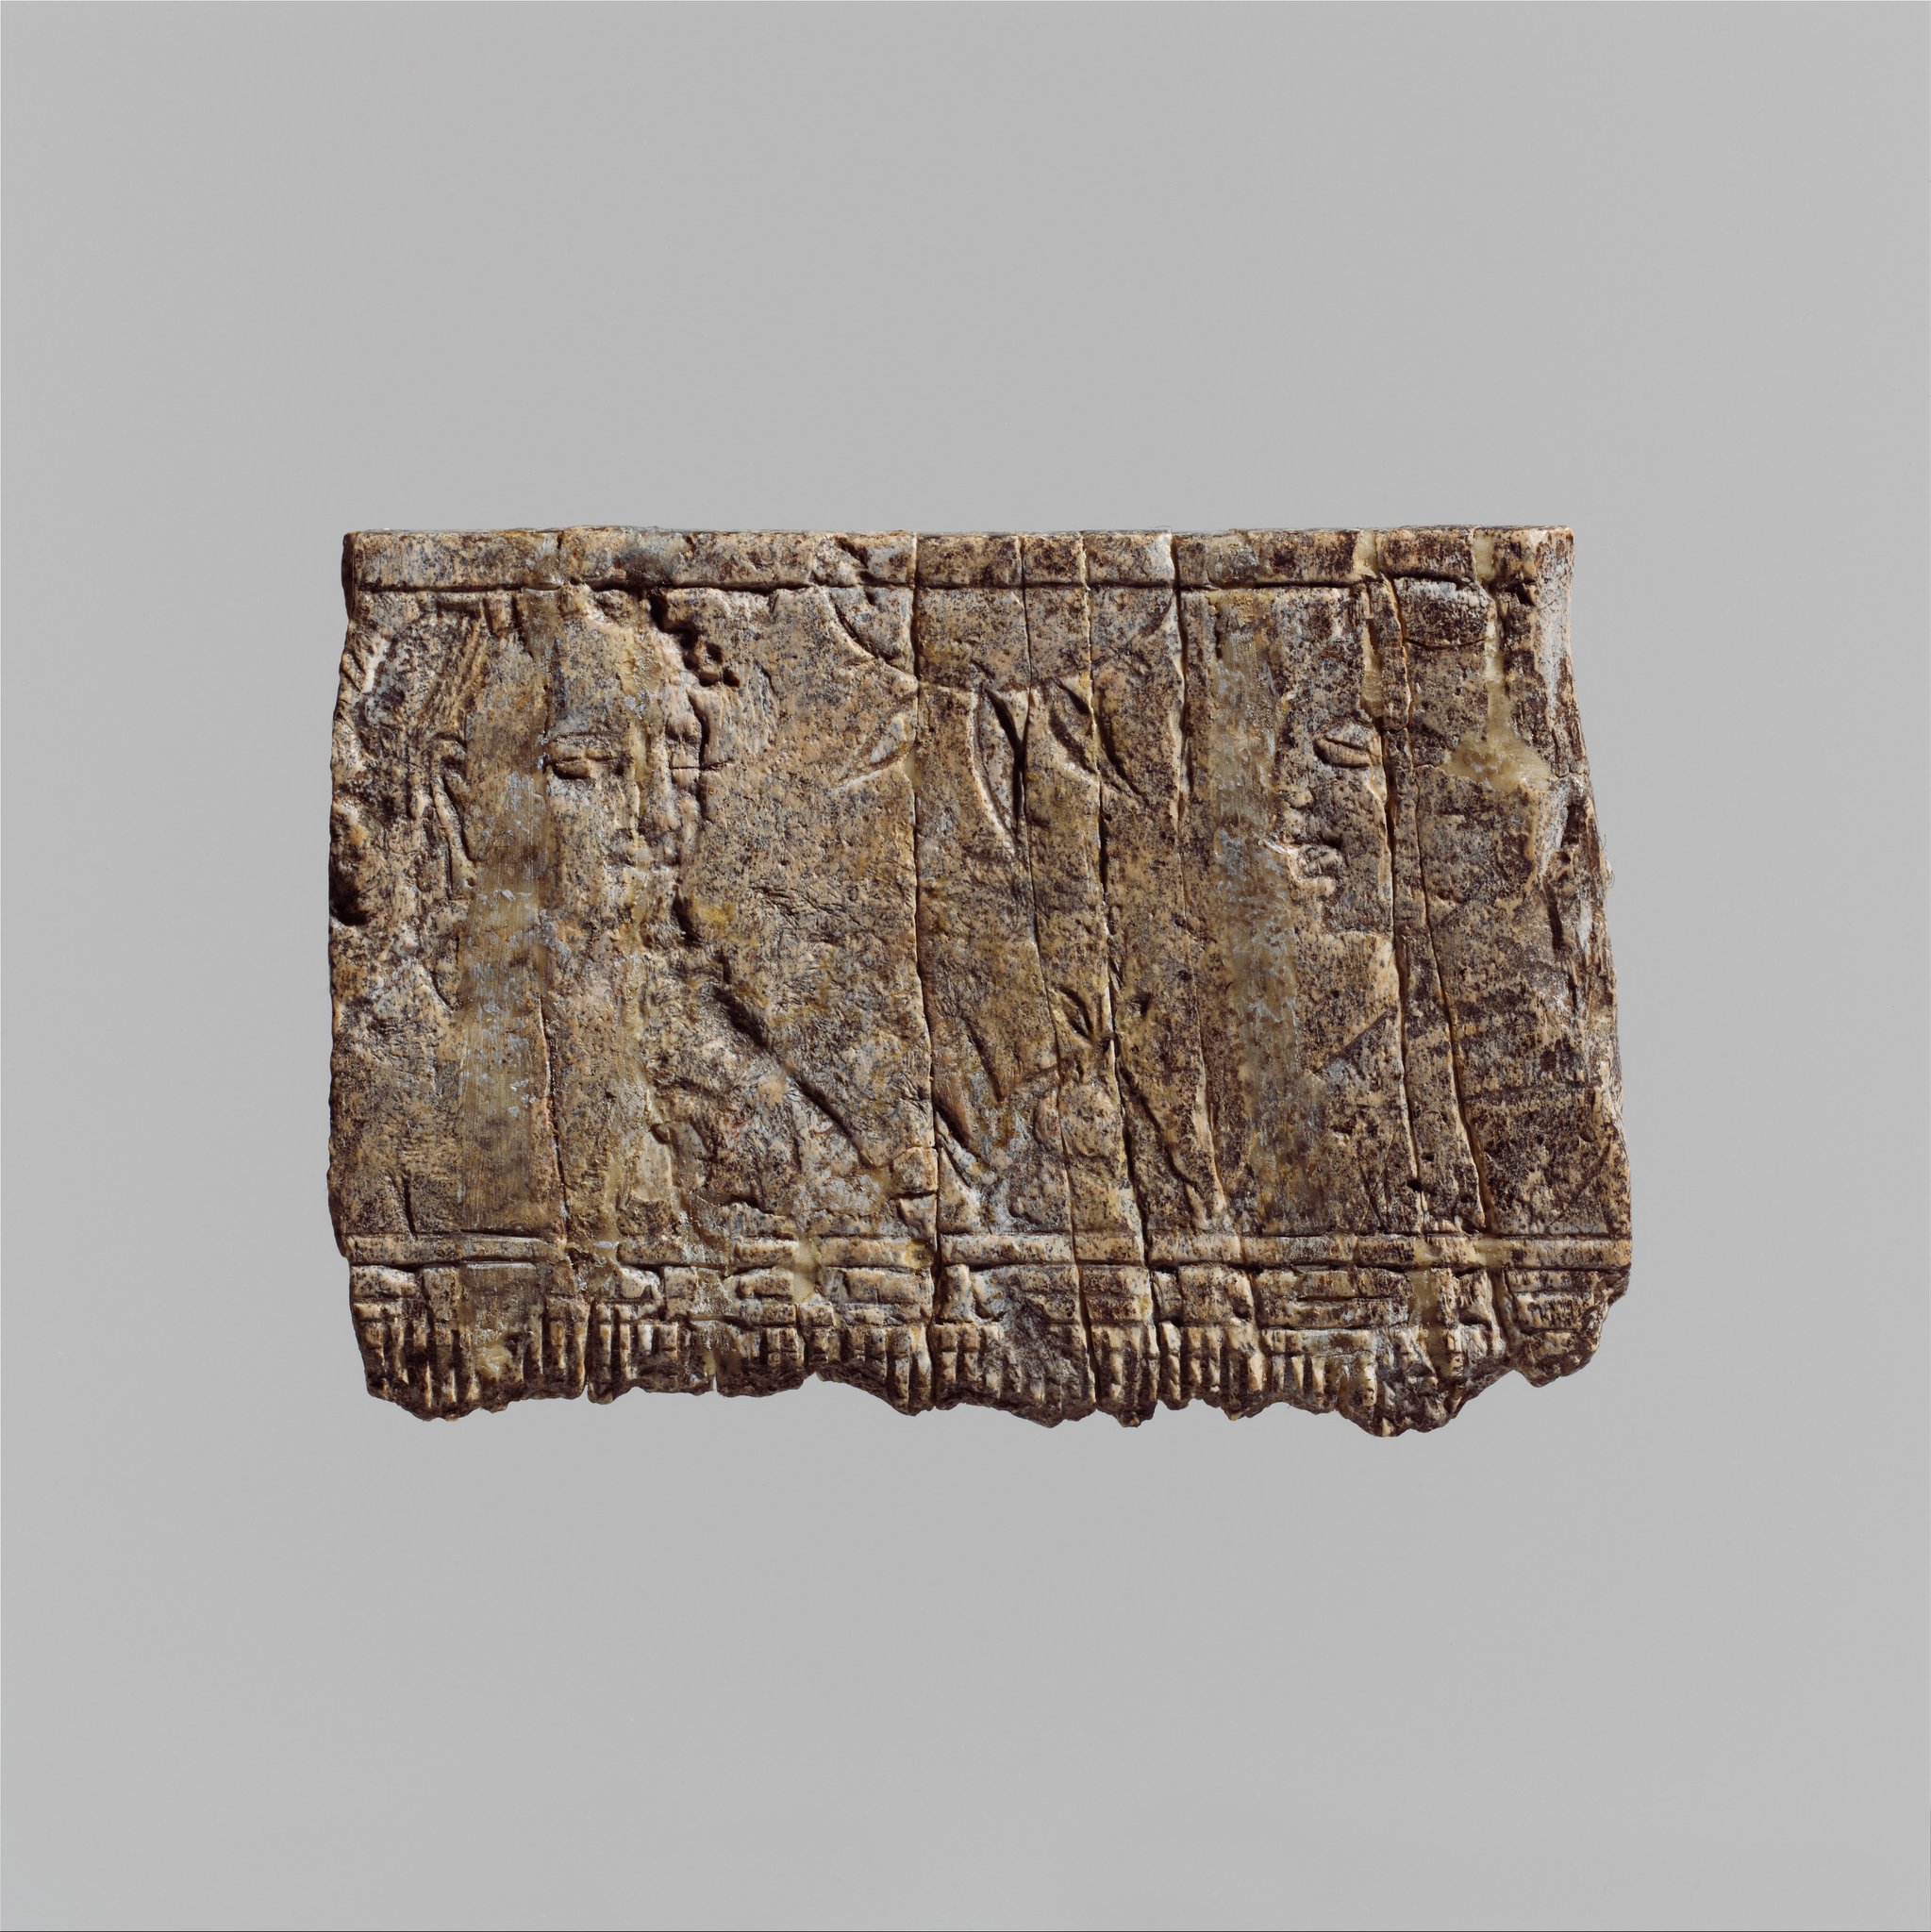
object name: comb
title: Fragment of an Ivory Comb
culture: afghan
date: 1-300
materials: ivory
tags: satavahana